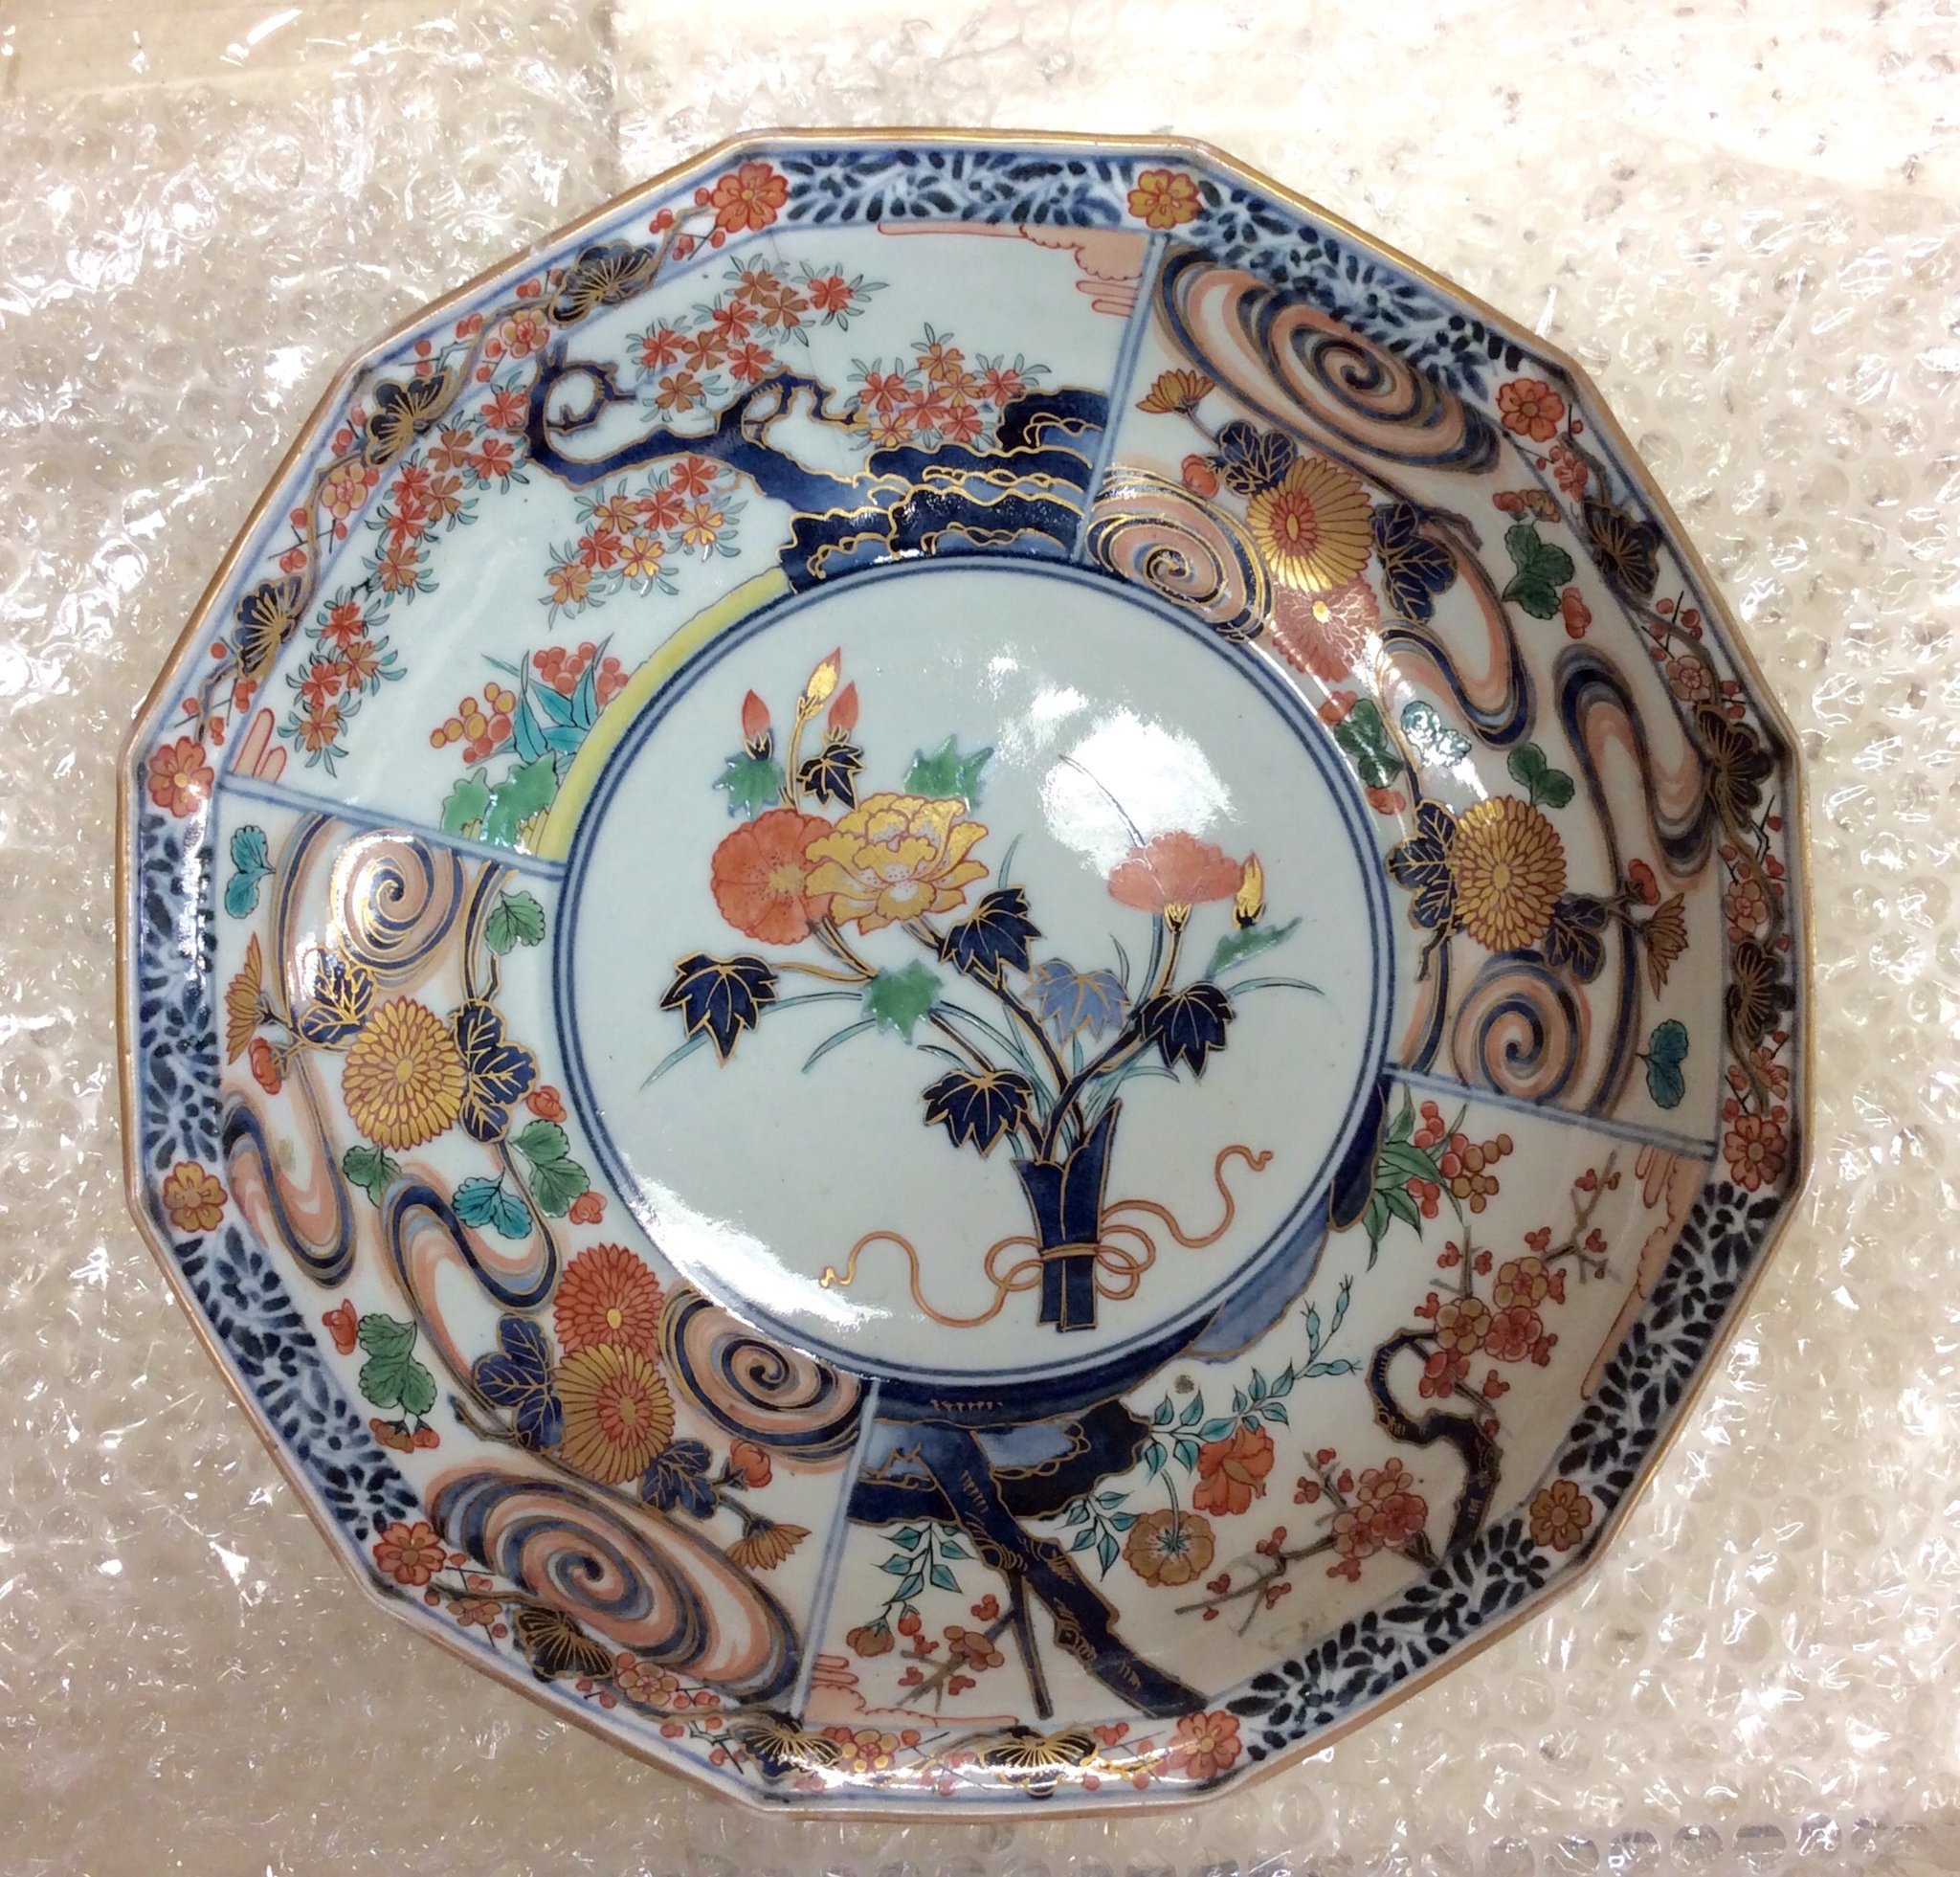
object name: cup with cover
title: Cup and Cover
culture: japanese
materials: porcelain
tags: flowers